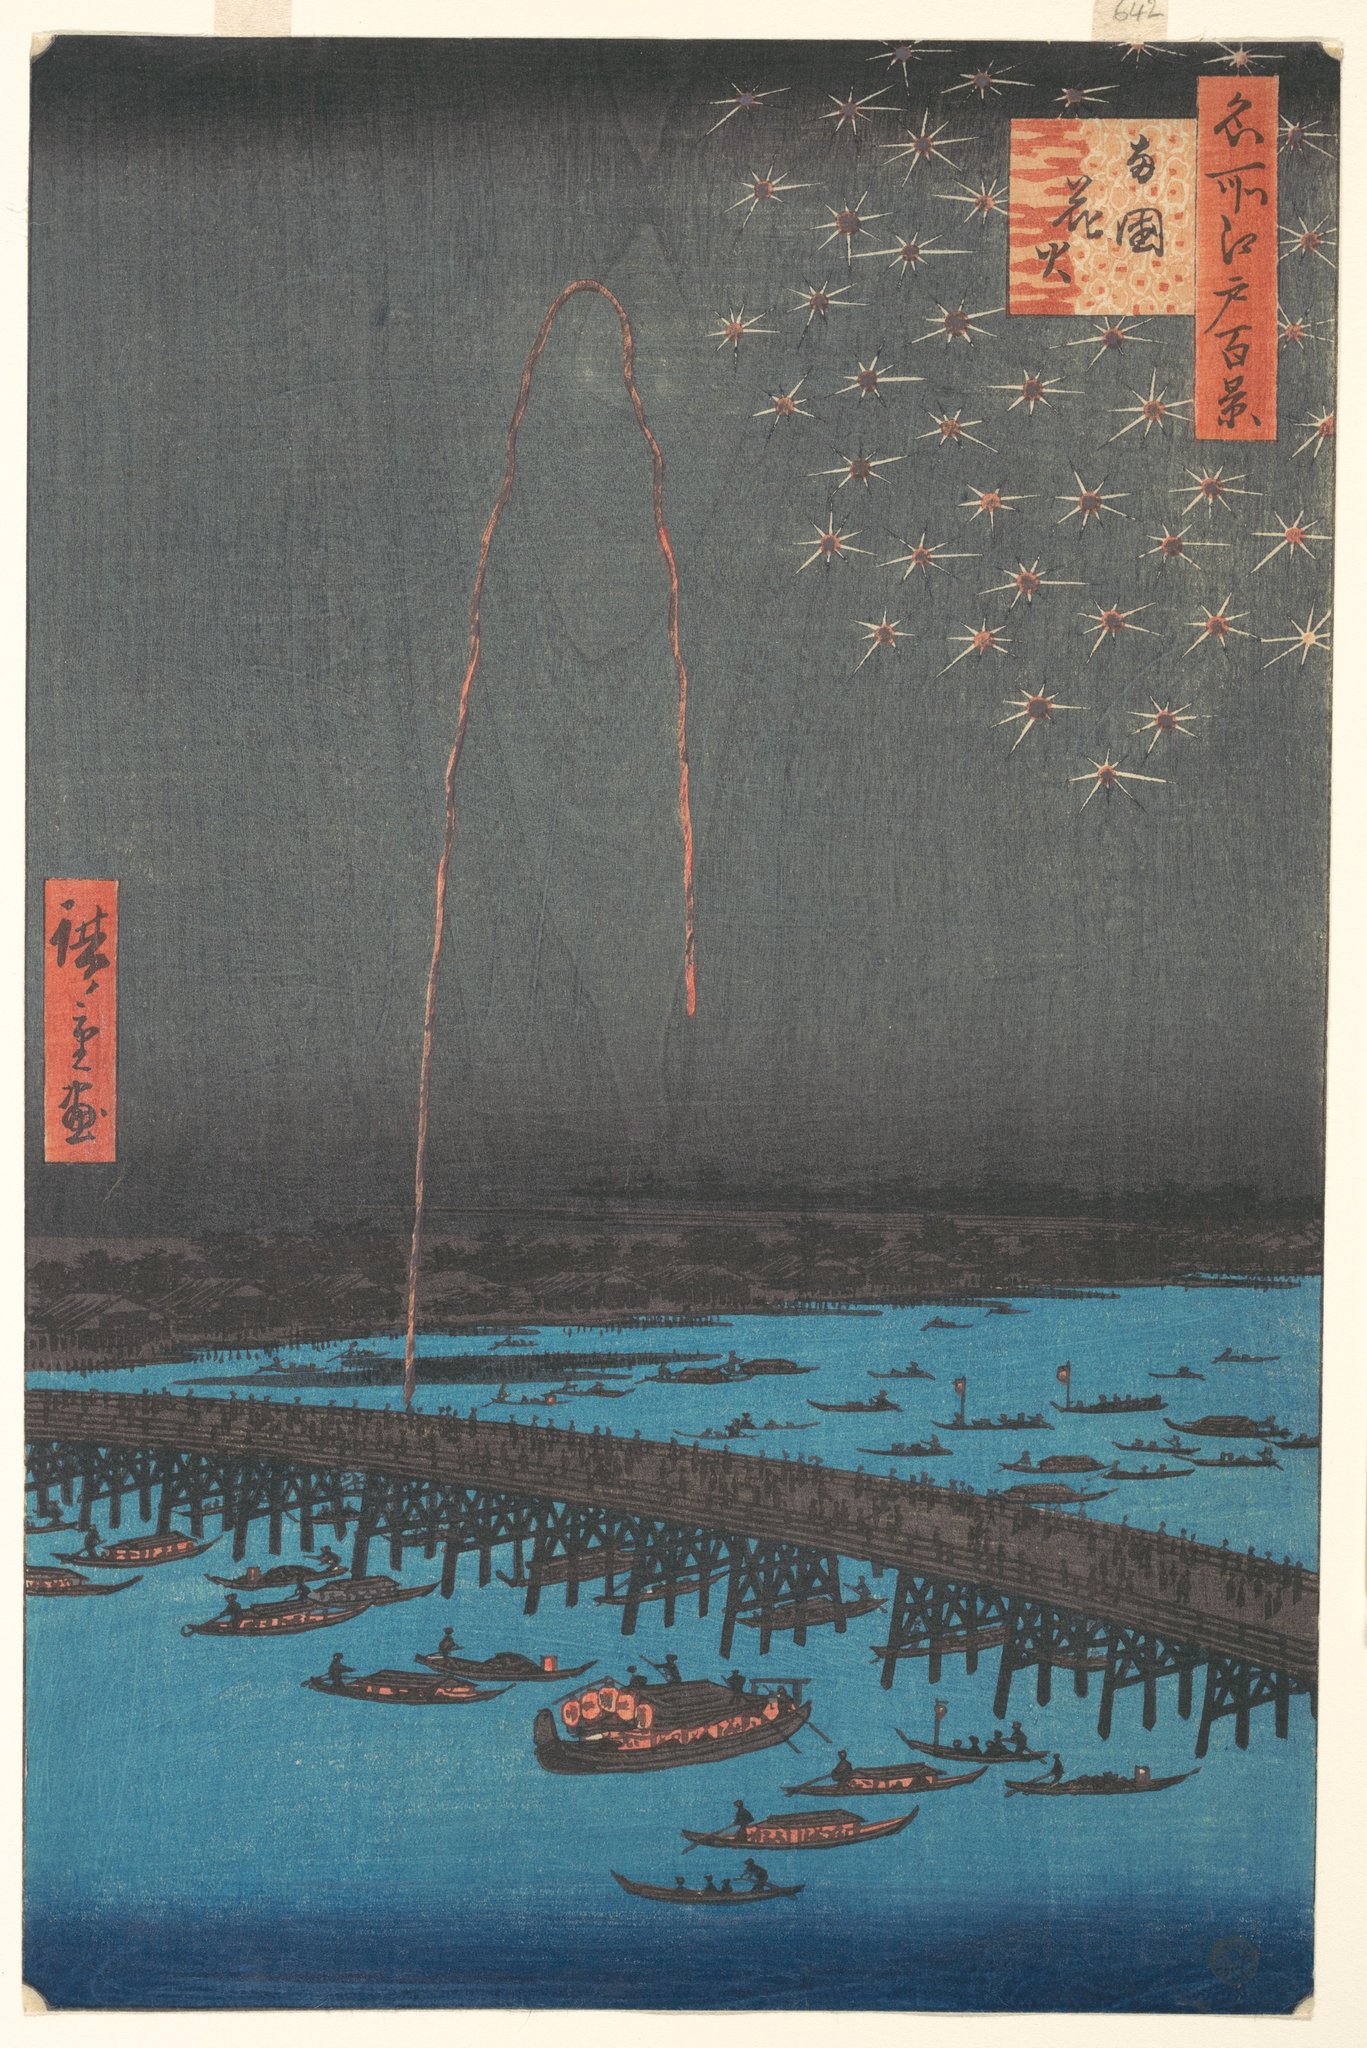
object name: print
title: Fireworks at Ryōgoku Bridge, from the series One Hundred Famous Views of Edo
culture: japanese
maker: utagawa hiroshige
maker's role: artist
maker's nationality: japanese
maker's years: 1797-1858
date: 1858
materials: ink, paper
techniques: woodblock print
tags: bridges,fireworks,boats